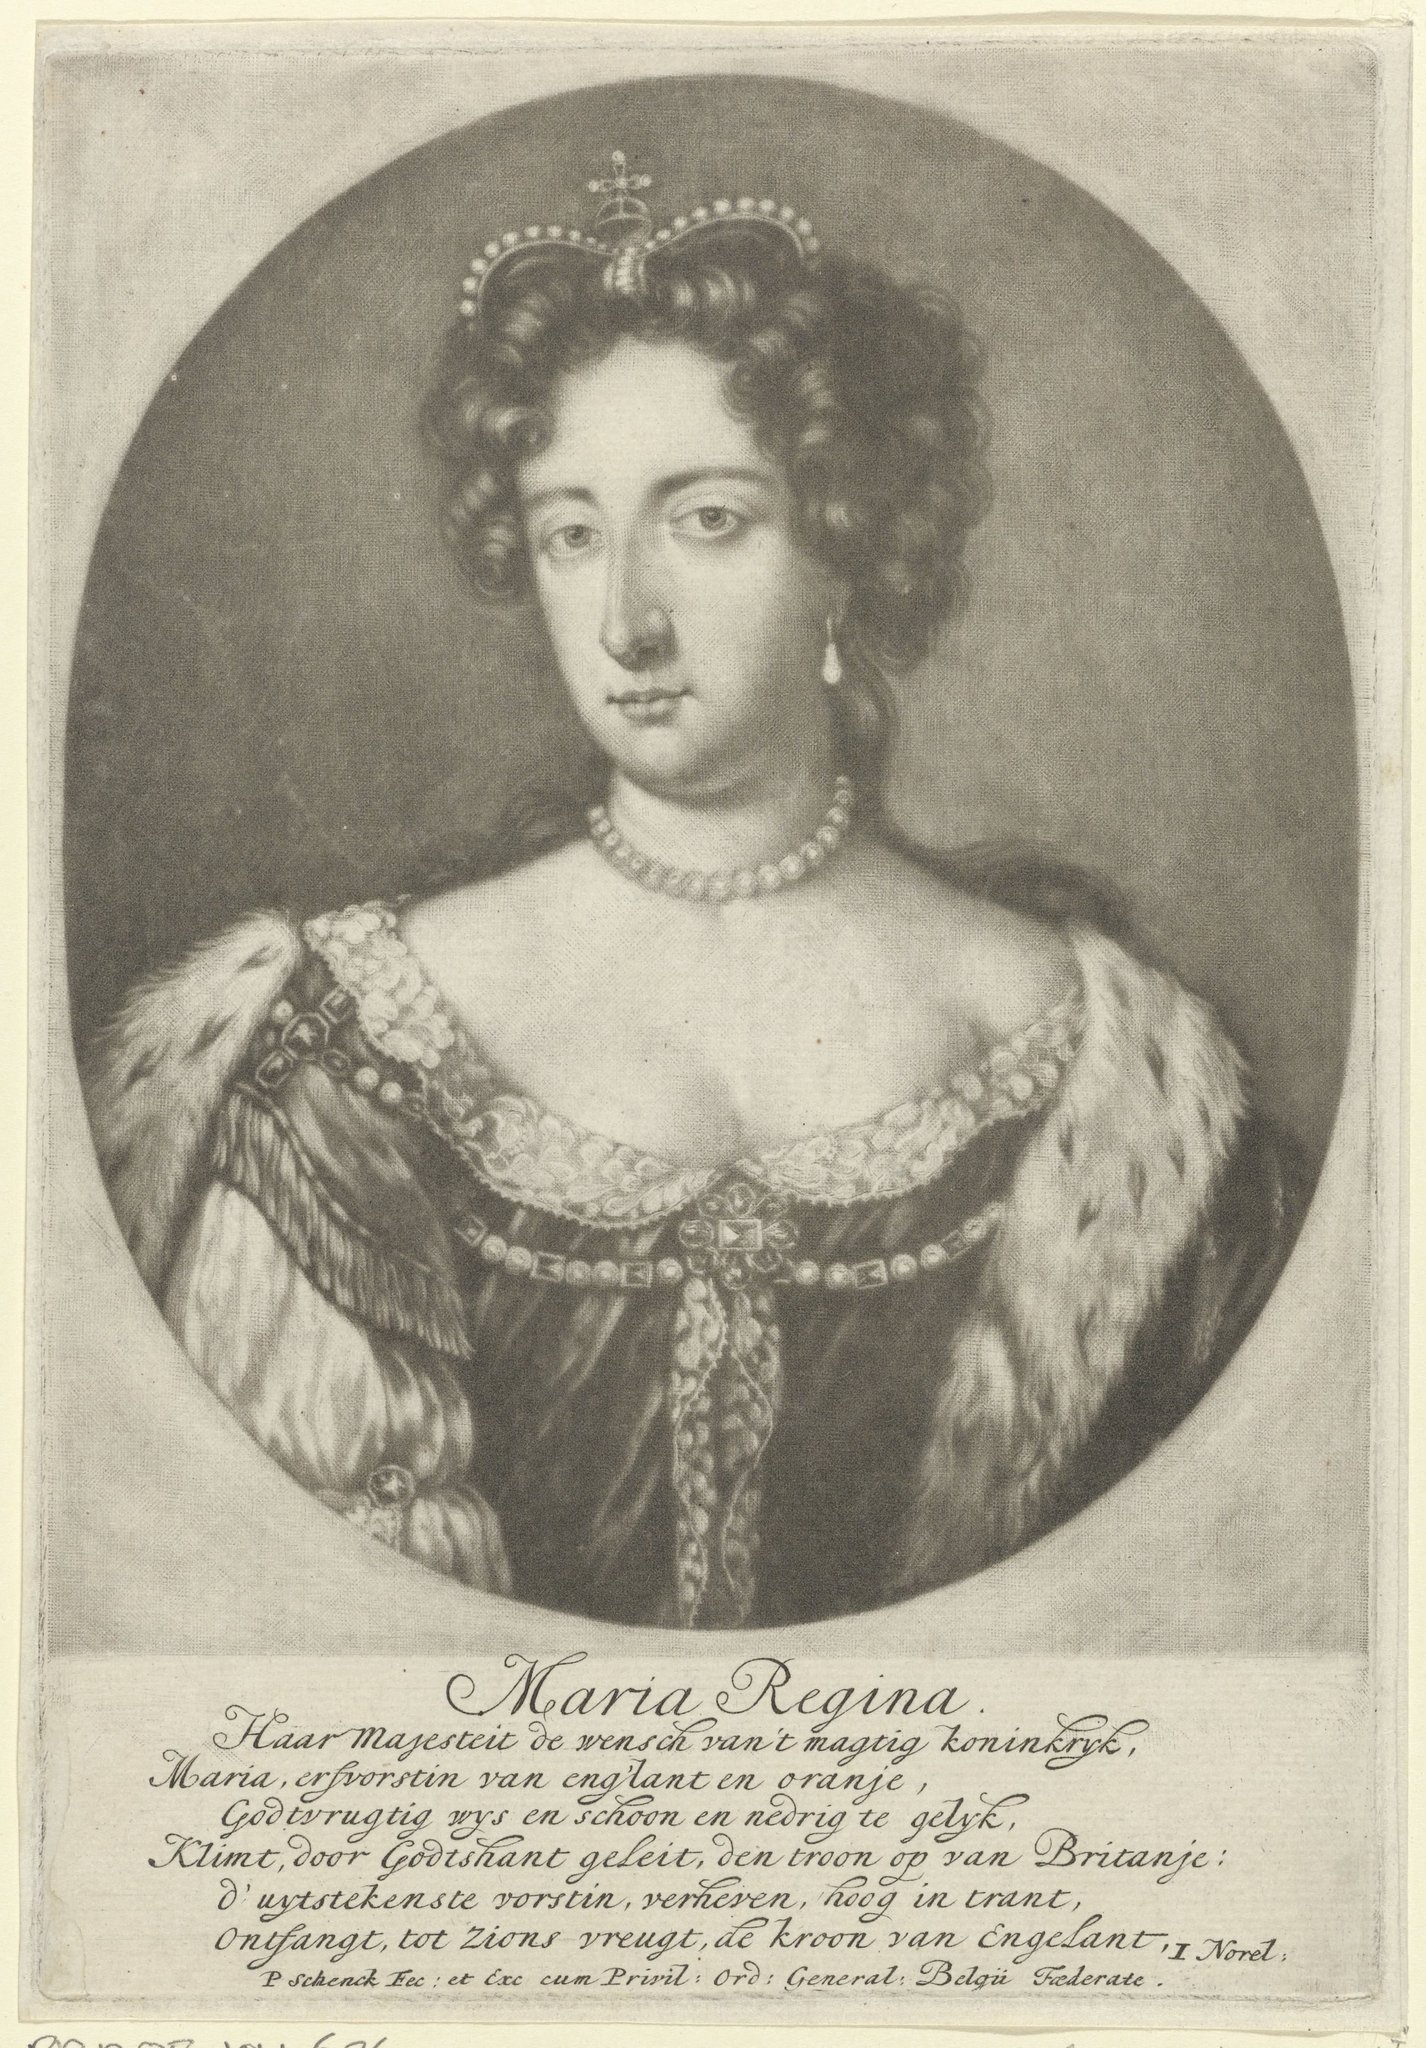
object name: print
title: Portret van Maria II Stuart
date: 1688-1711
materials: paper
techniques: mezzotint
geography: amsterdam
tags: london, maria ii stuart (koningin van engeland, schotland en ierland)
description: Portret van Maria II met een kroon in een ovaal. In de ondermarge haar naam, haar titel en zes regels Nederlandse tekst.